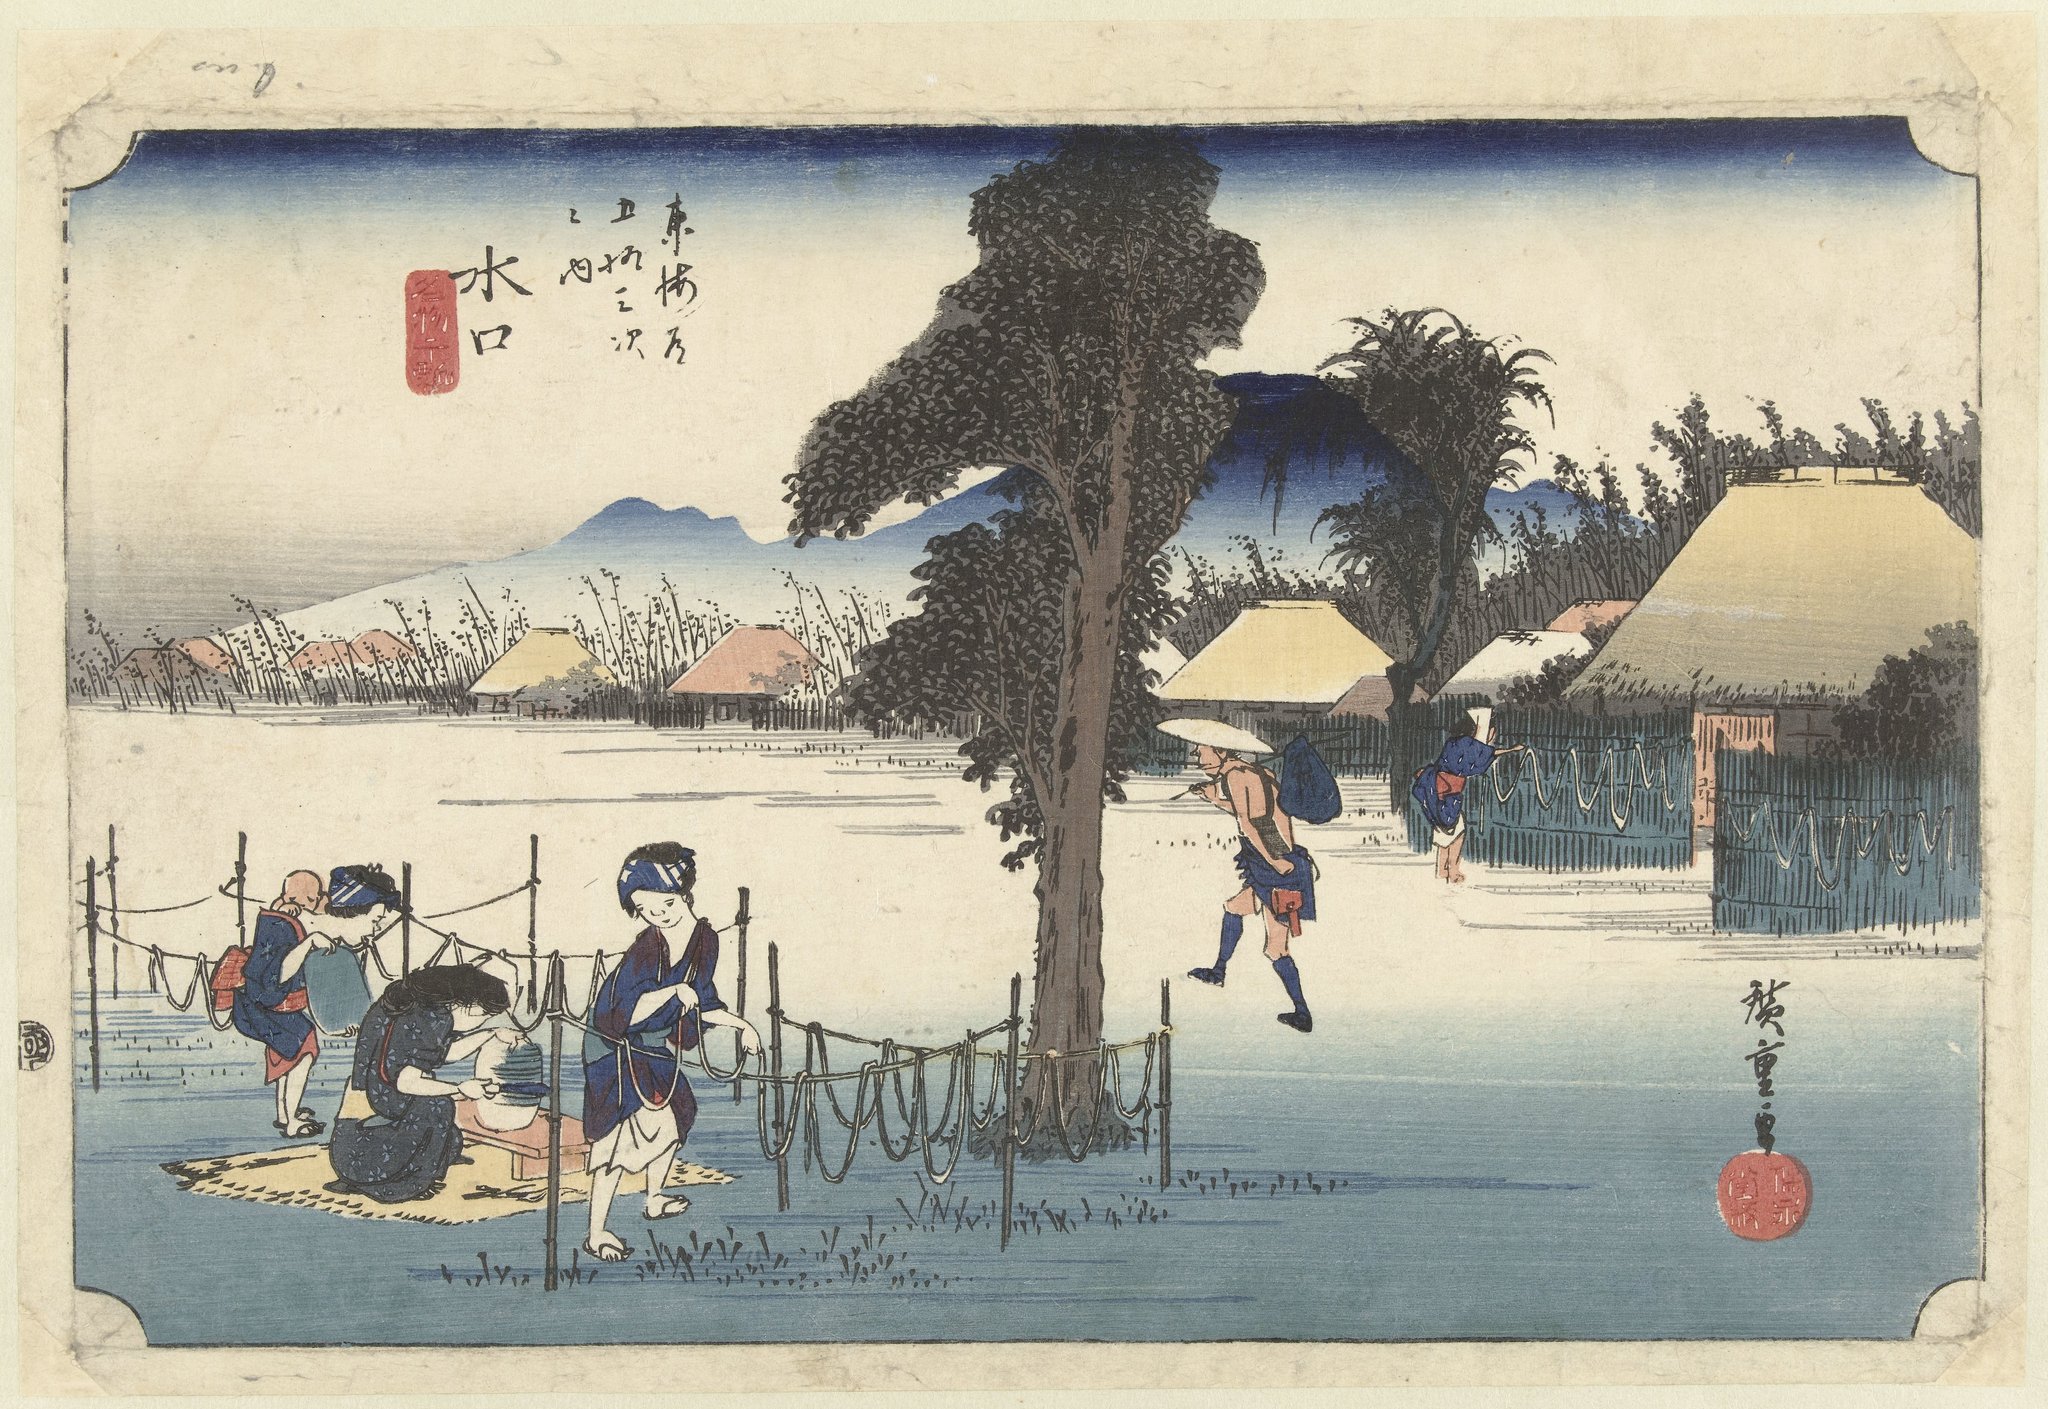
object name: print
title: De 53 stations van de Tokaido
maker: utagawa hiroshige (i)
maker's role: draughtsman, print maker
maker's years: 1797-1858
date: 1828-1835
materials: paper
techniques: woodcut, nishiki e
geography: japan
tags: city-view, and landscape with man-made constructions, preparation of food - cc - in the open air, 'en route', traveller under way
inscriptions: signature: ‘Hiroshige ga’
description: Een reiziger lopend door het dorp Minakuchi, waar vrouwen in de weer zijn met de productie van kanpyo (gedroogde slierten kalebas).